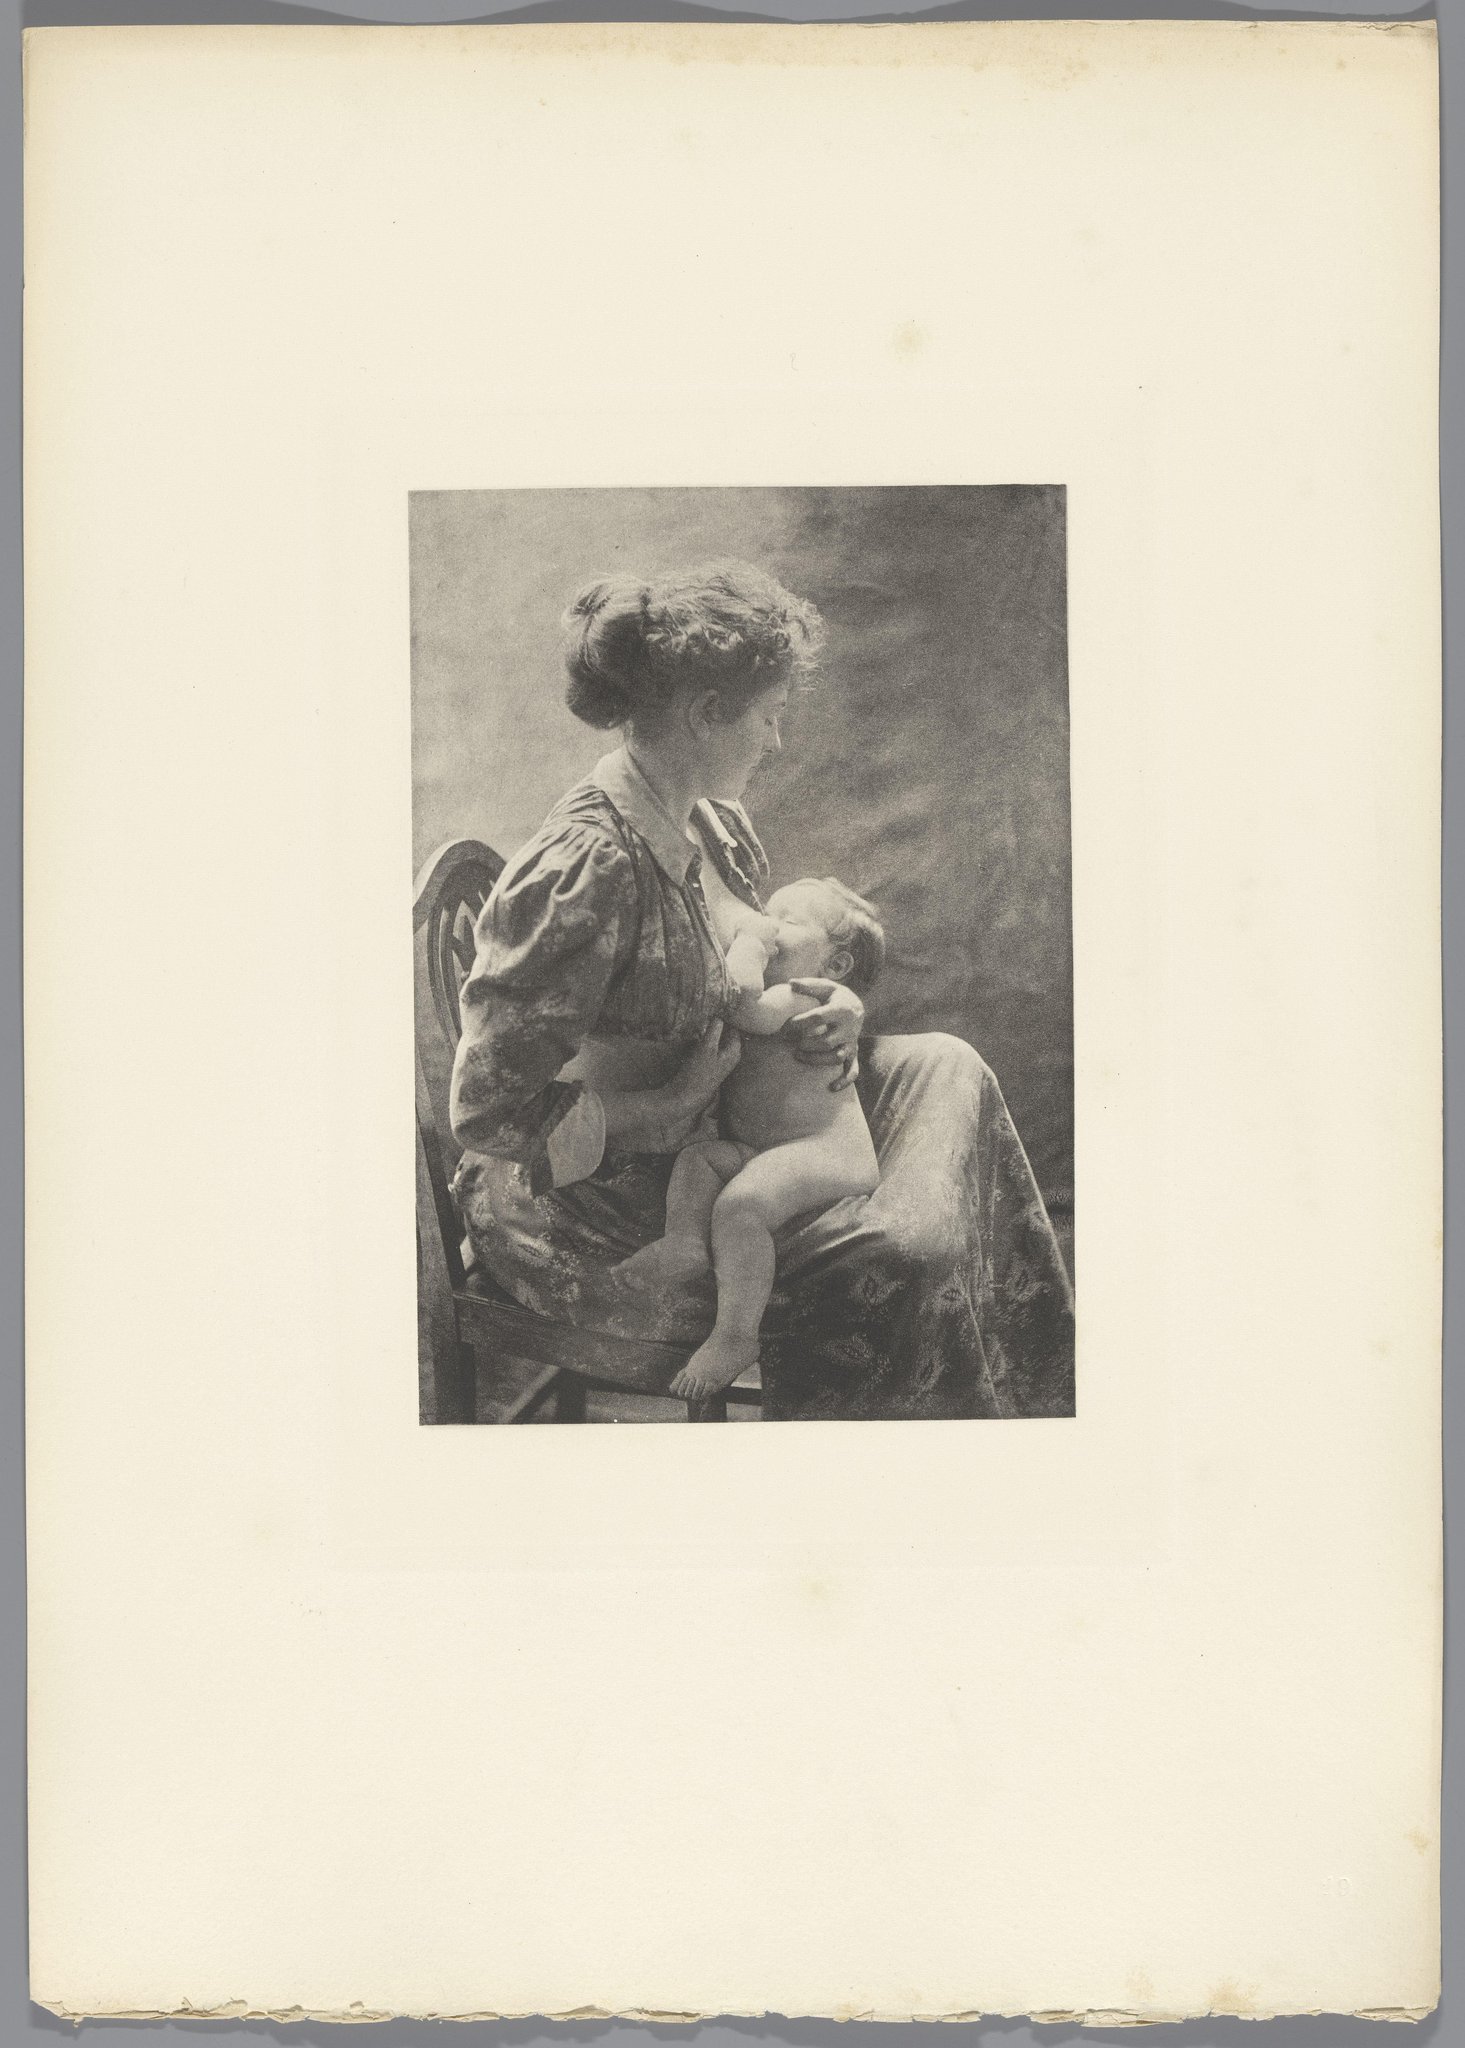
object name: photomechanical print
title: Madone moderne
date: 1891-1896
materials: paper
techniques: photoaquatint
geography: paris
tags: breasts giving milk - aa - female human figure, historical persons not known by name - bb - woman, feeding a baby, mother and baby or young child